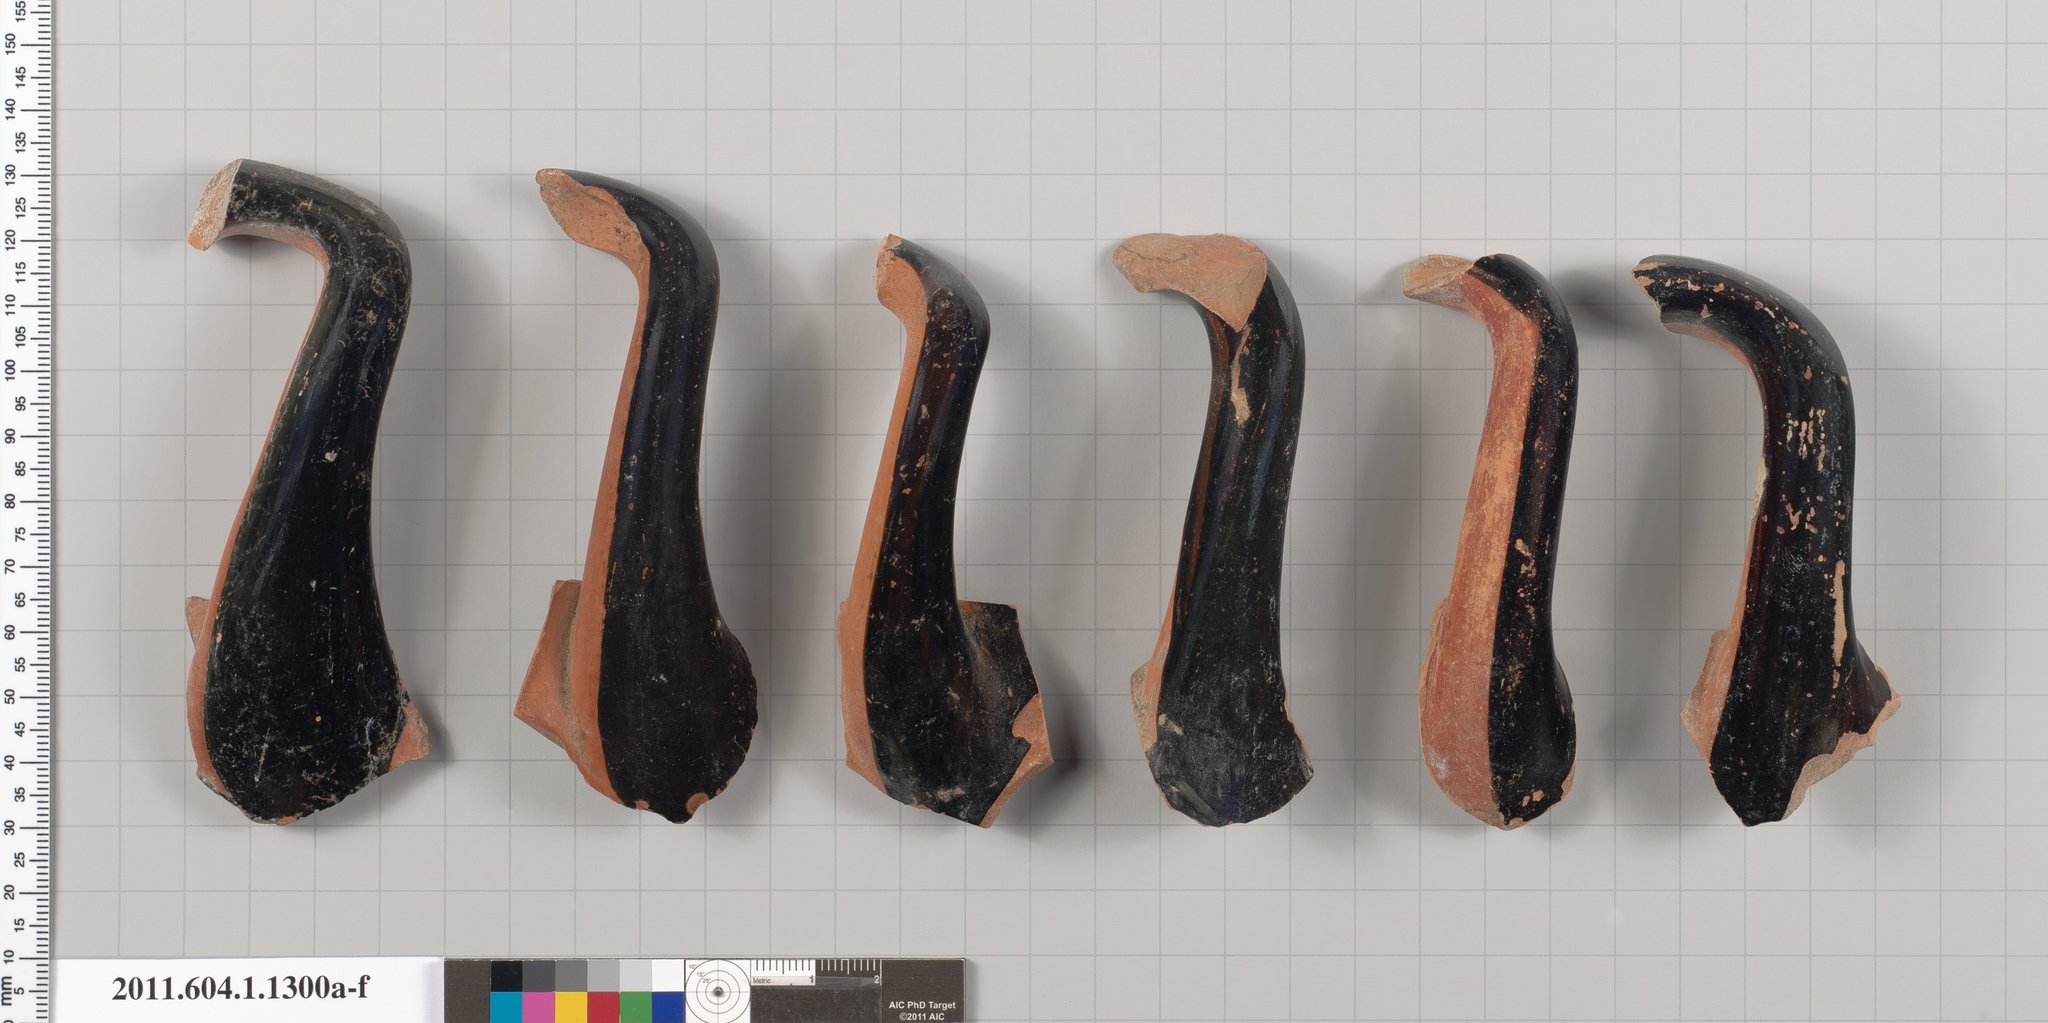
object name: kylix fragment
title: Terracotta fragments of kylikes (drinking cups)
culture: greek, attic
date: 500-401 BCE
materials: terracotta